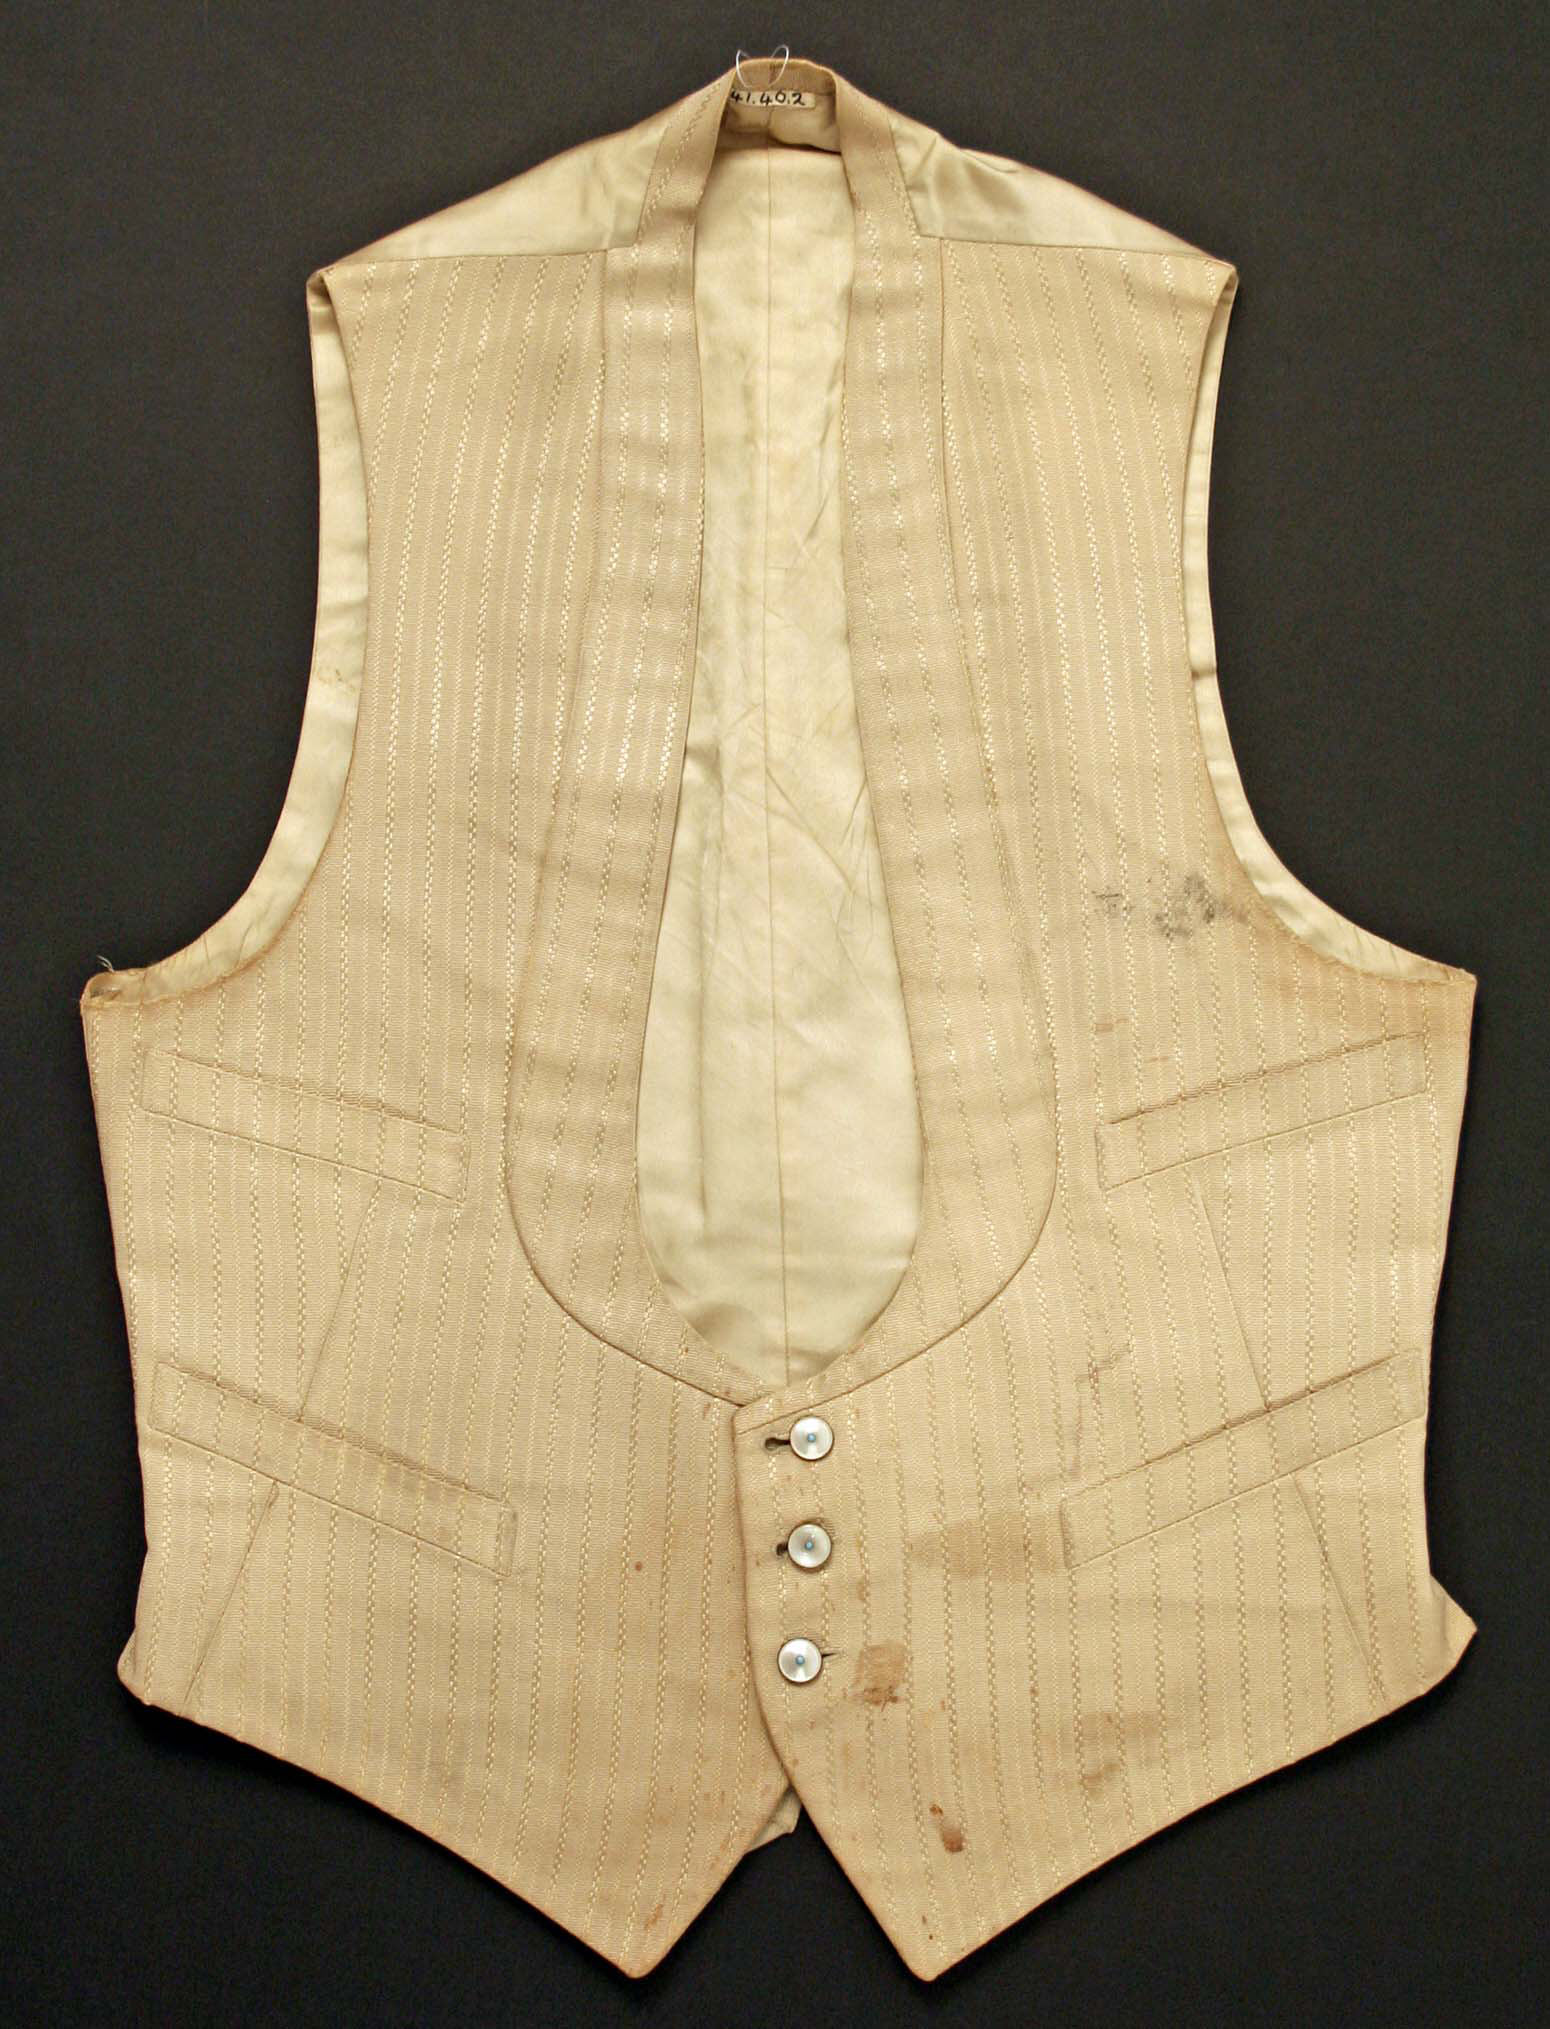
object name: vest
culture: american or european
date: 1895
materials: silk